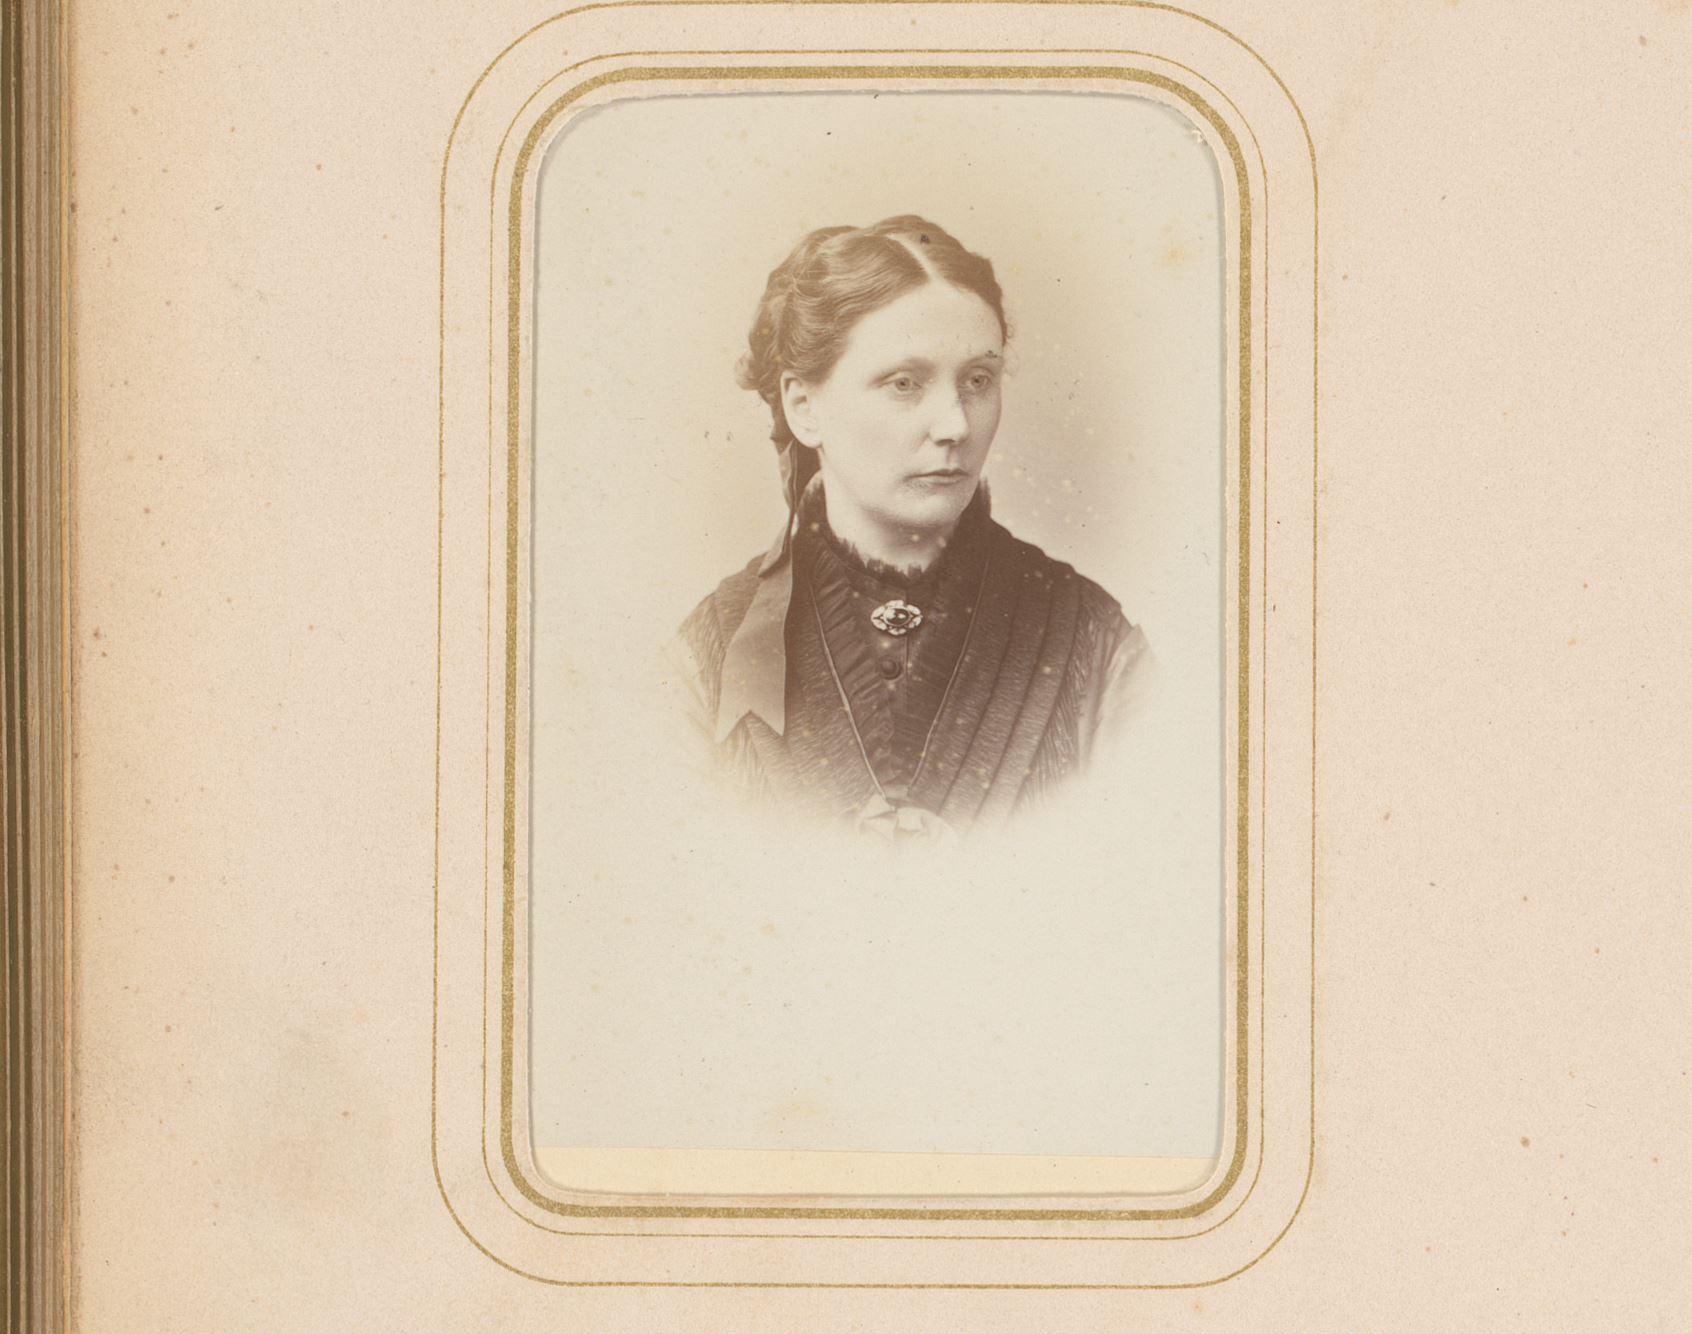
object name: photograph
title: Portret van een vrouw met lint in het haar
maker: thomas fall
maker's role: fotograaf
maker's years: 1833-1900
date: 1860-1880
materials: cardboard, photographic support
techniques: albumen print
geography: london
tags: historical persons - bb - woman, hairdress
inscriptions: number: ‘11040-8’, inscription: ‘FOR MANY YEARS CHIEF PHOTOGRAPHER TO ELLIOTT & FRY./ T. Fall,/ 9, Baker Street./ Portman Square./ W./ This Negative is preserved./ Enlargements can be had finished in/ Oil, Water or Crayon.’